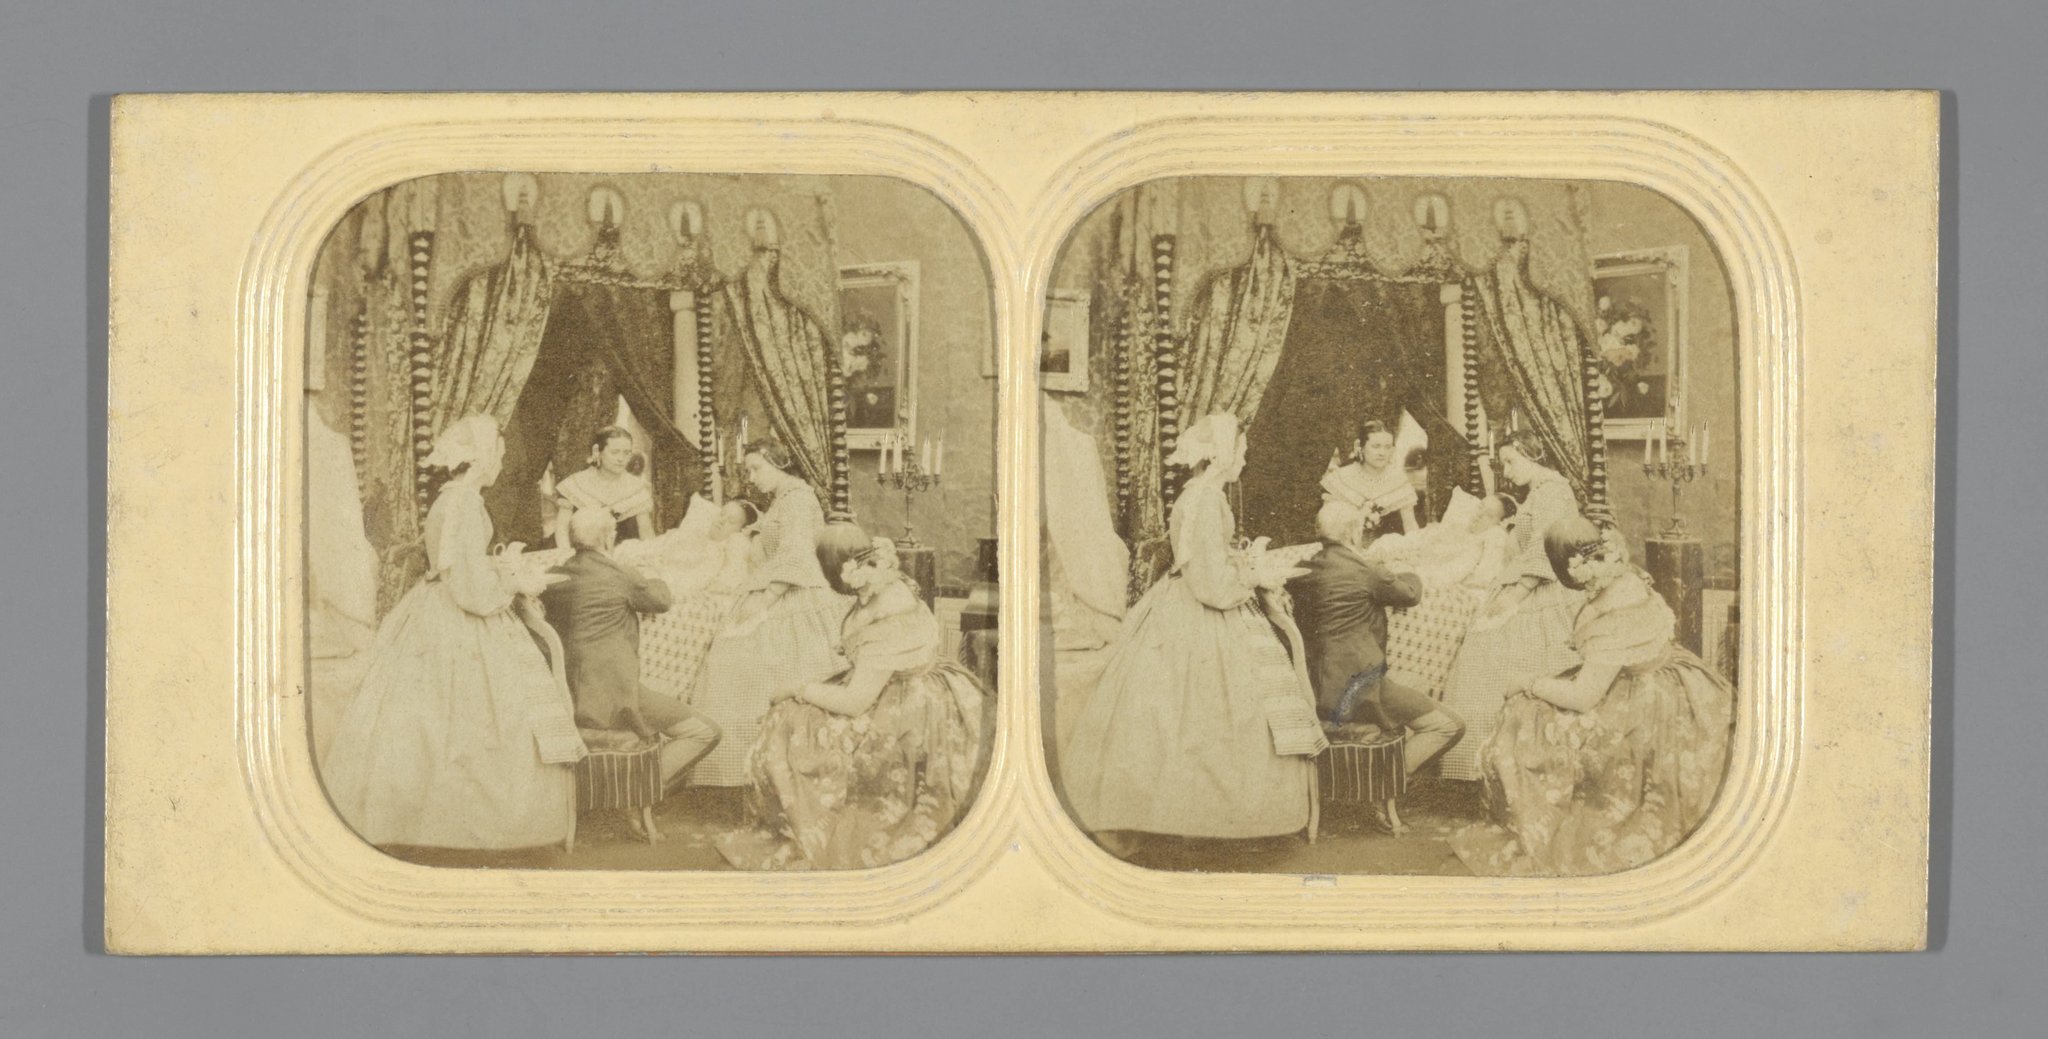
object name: tissue stereograph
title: Man en vier vrouwen rond zieke vrouw in bed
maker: Anonymous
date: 1855-1875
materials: cardboard, paper, photographic support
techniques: albumen print, cutting, hand coloring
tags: sick-bed